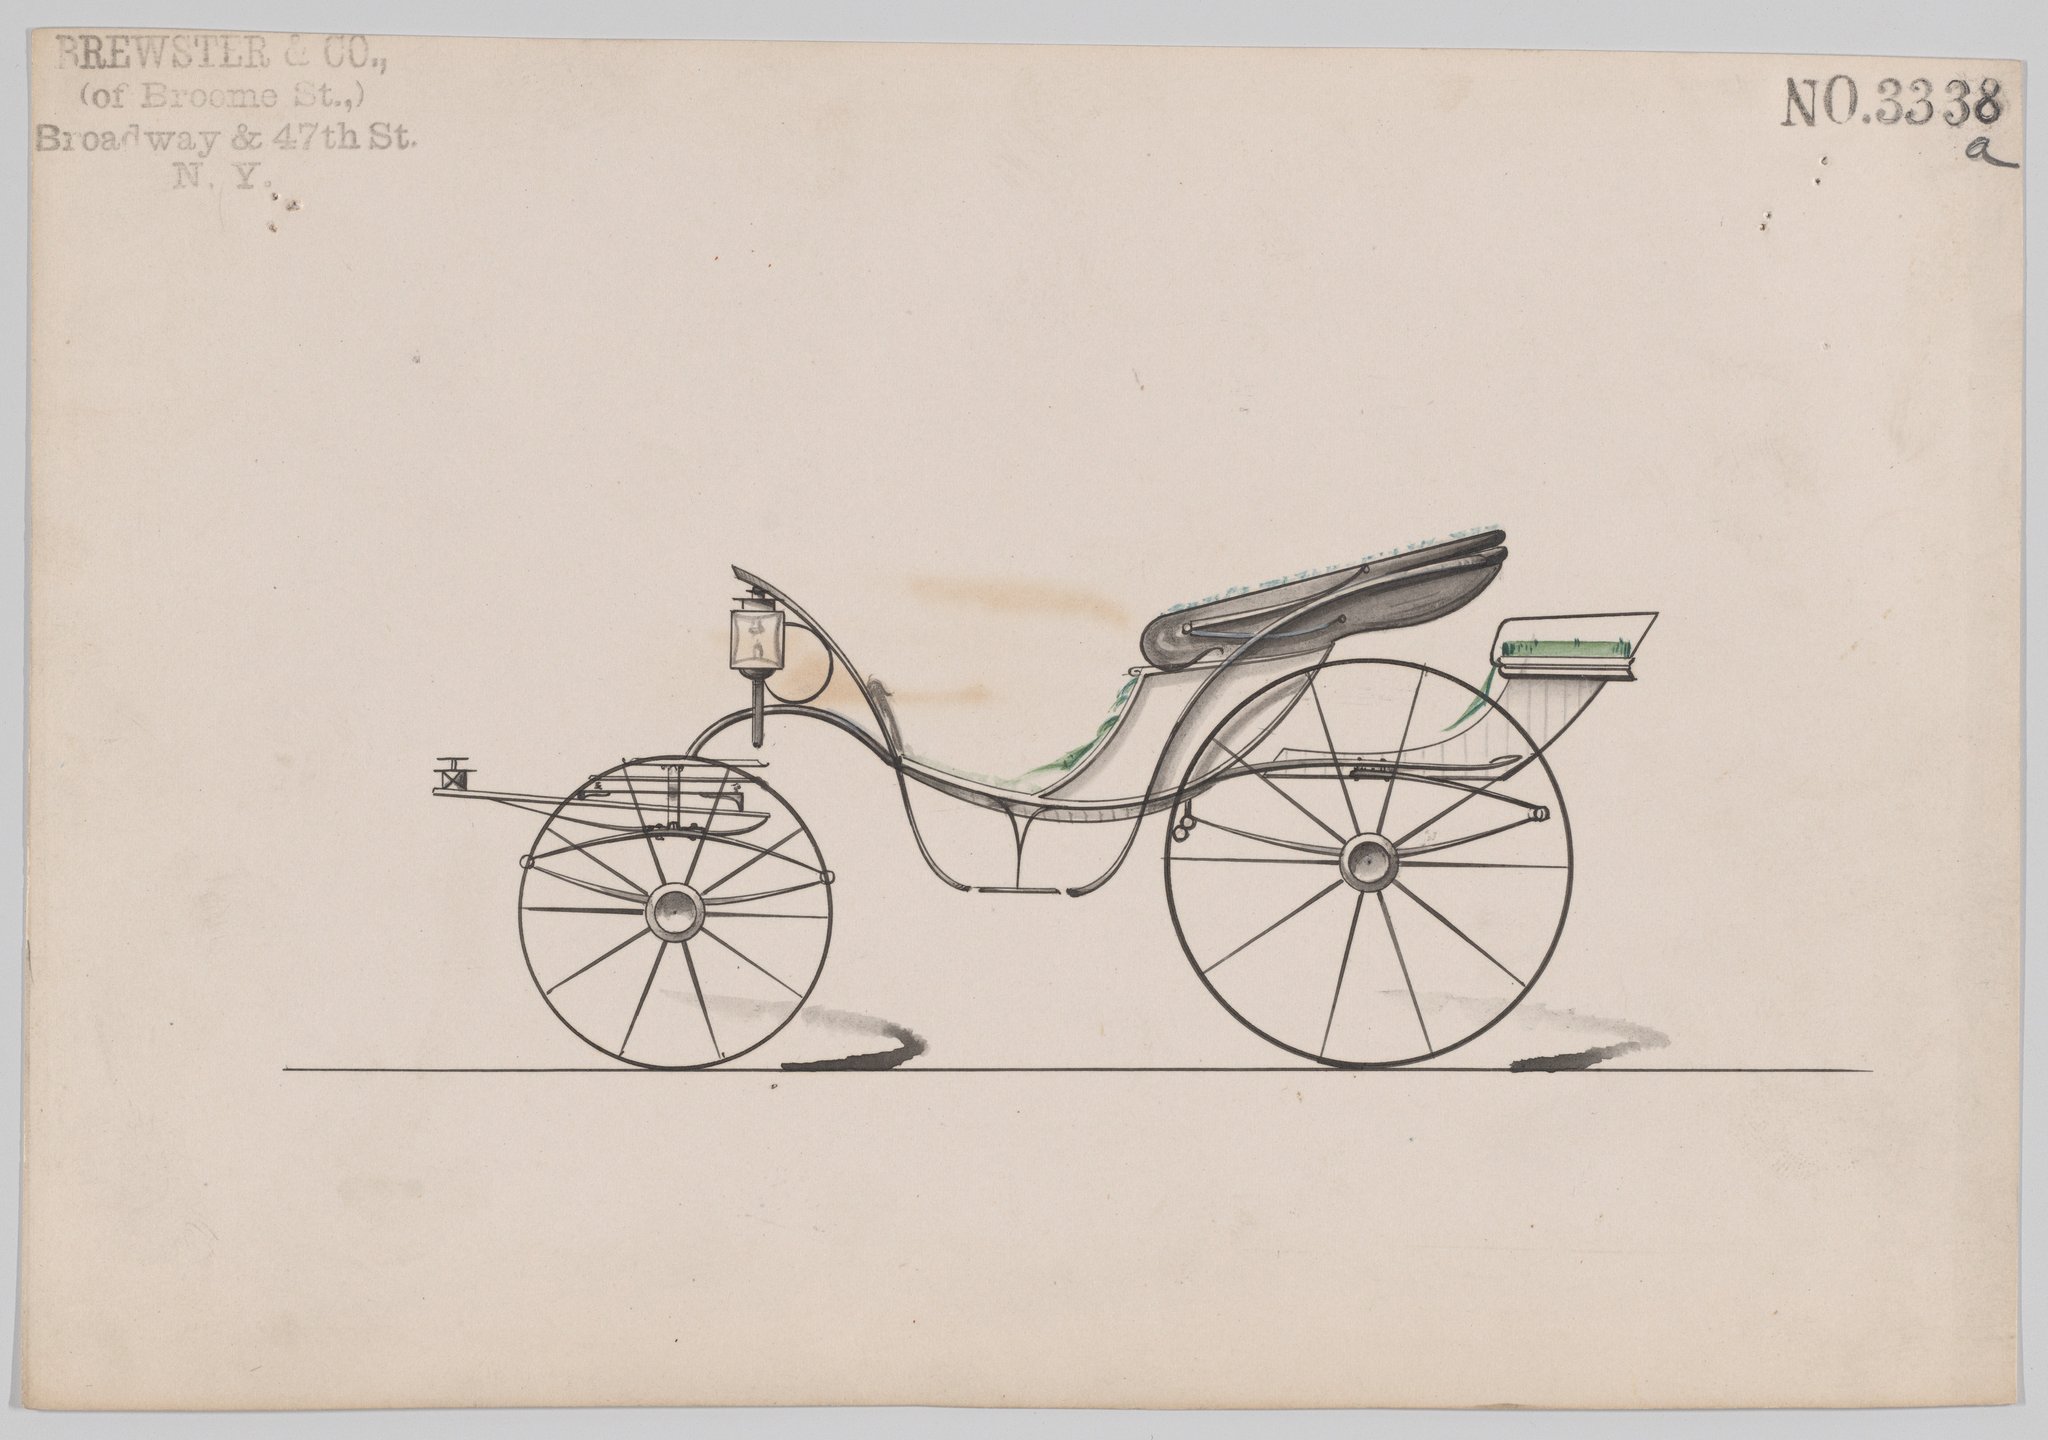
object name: drawing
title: Design for Pony Phaeton, no. 3338a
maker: brewster & co.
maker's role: manufacturer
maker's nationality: american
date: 1877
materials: gouache, ink, watercolor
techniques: pen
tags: carriages